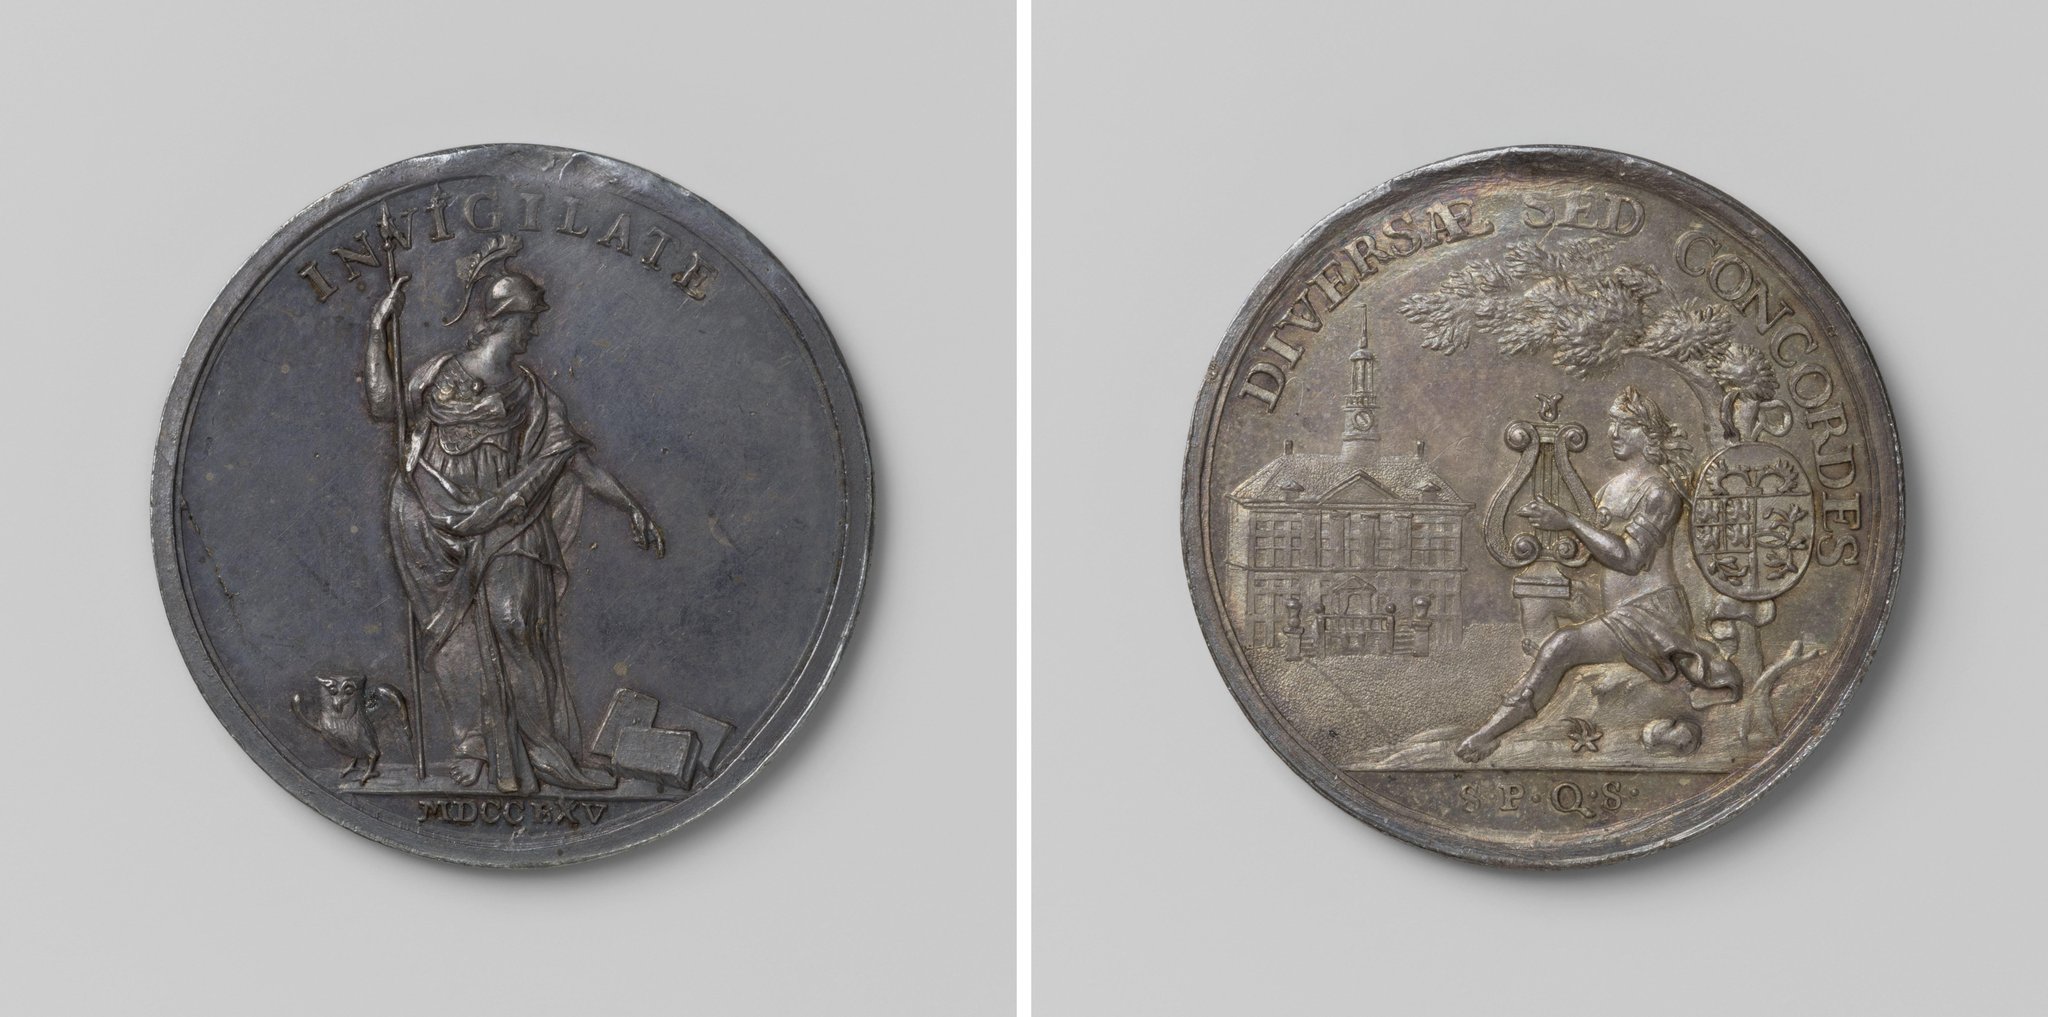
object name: council medal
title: Vroedschapspenning van de stad 's-Hertogenbosch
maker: theodorus everardus van berckel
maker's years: 1708-1770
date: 1765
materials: silver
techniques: striking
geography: den bosch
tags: den bosch